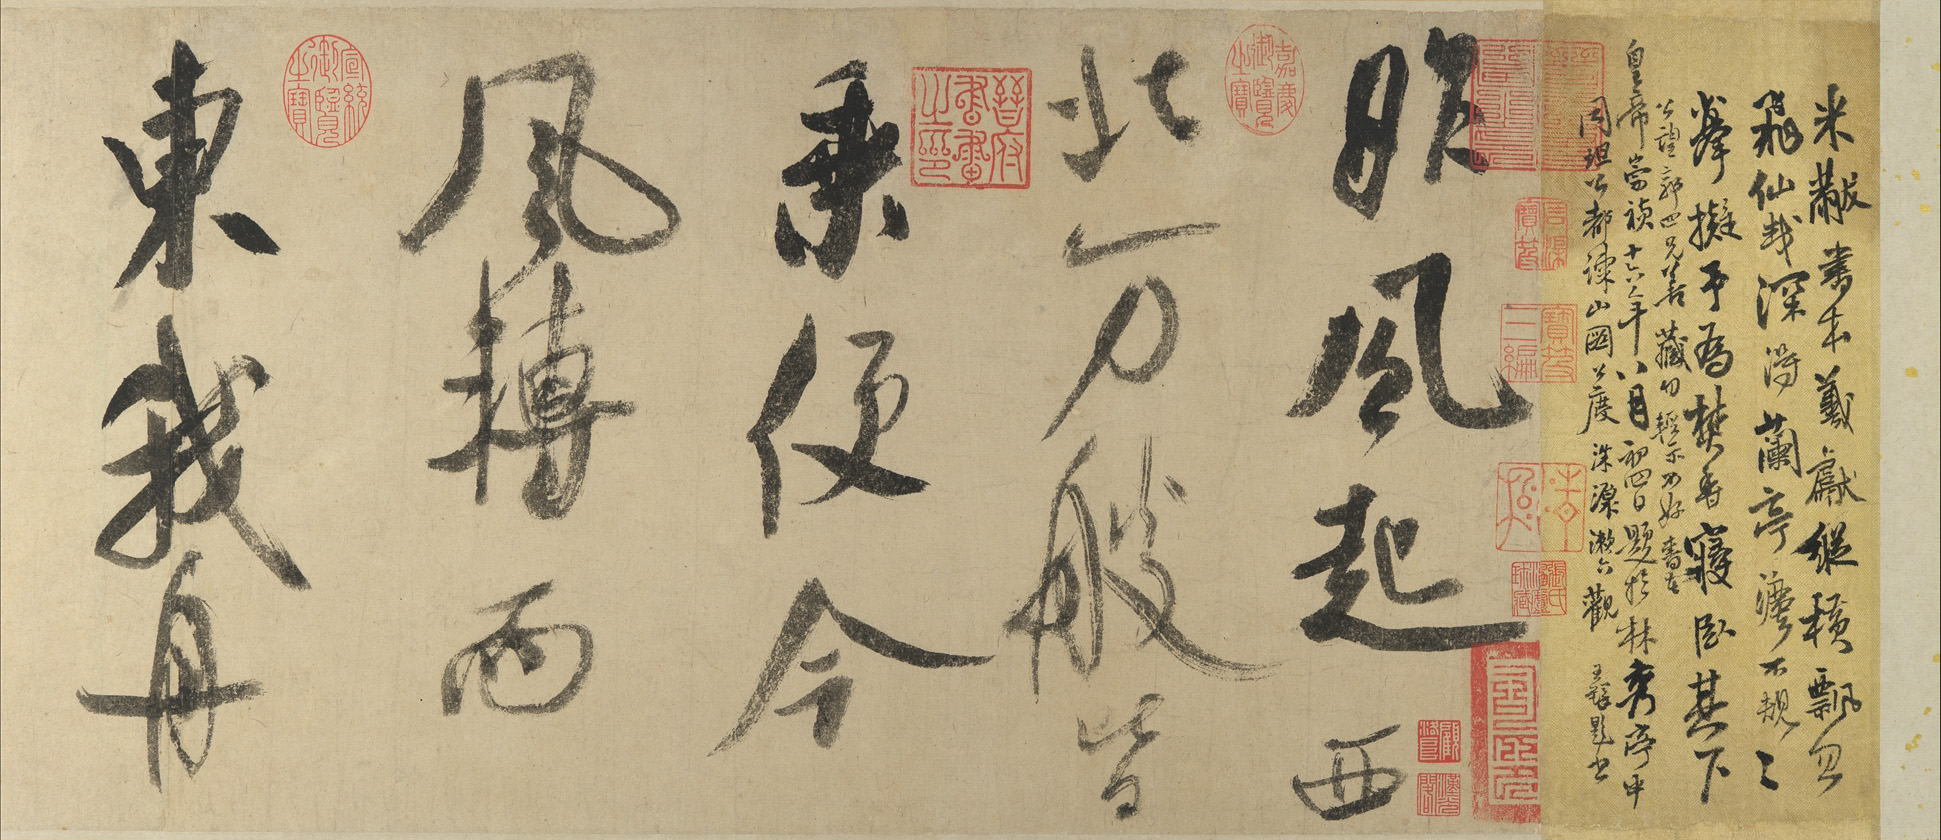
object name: handscroll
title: Poem Written in a Boat on the Wu River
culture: chinese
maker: mi fu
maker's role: calligrapher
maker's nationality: chinese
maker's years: 1051-1107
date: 1095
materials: ink, paper